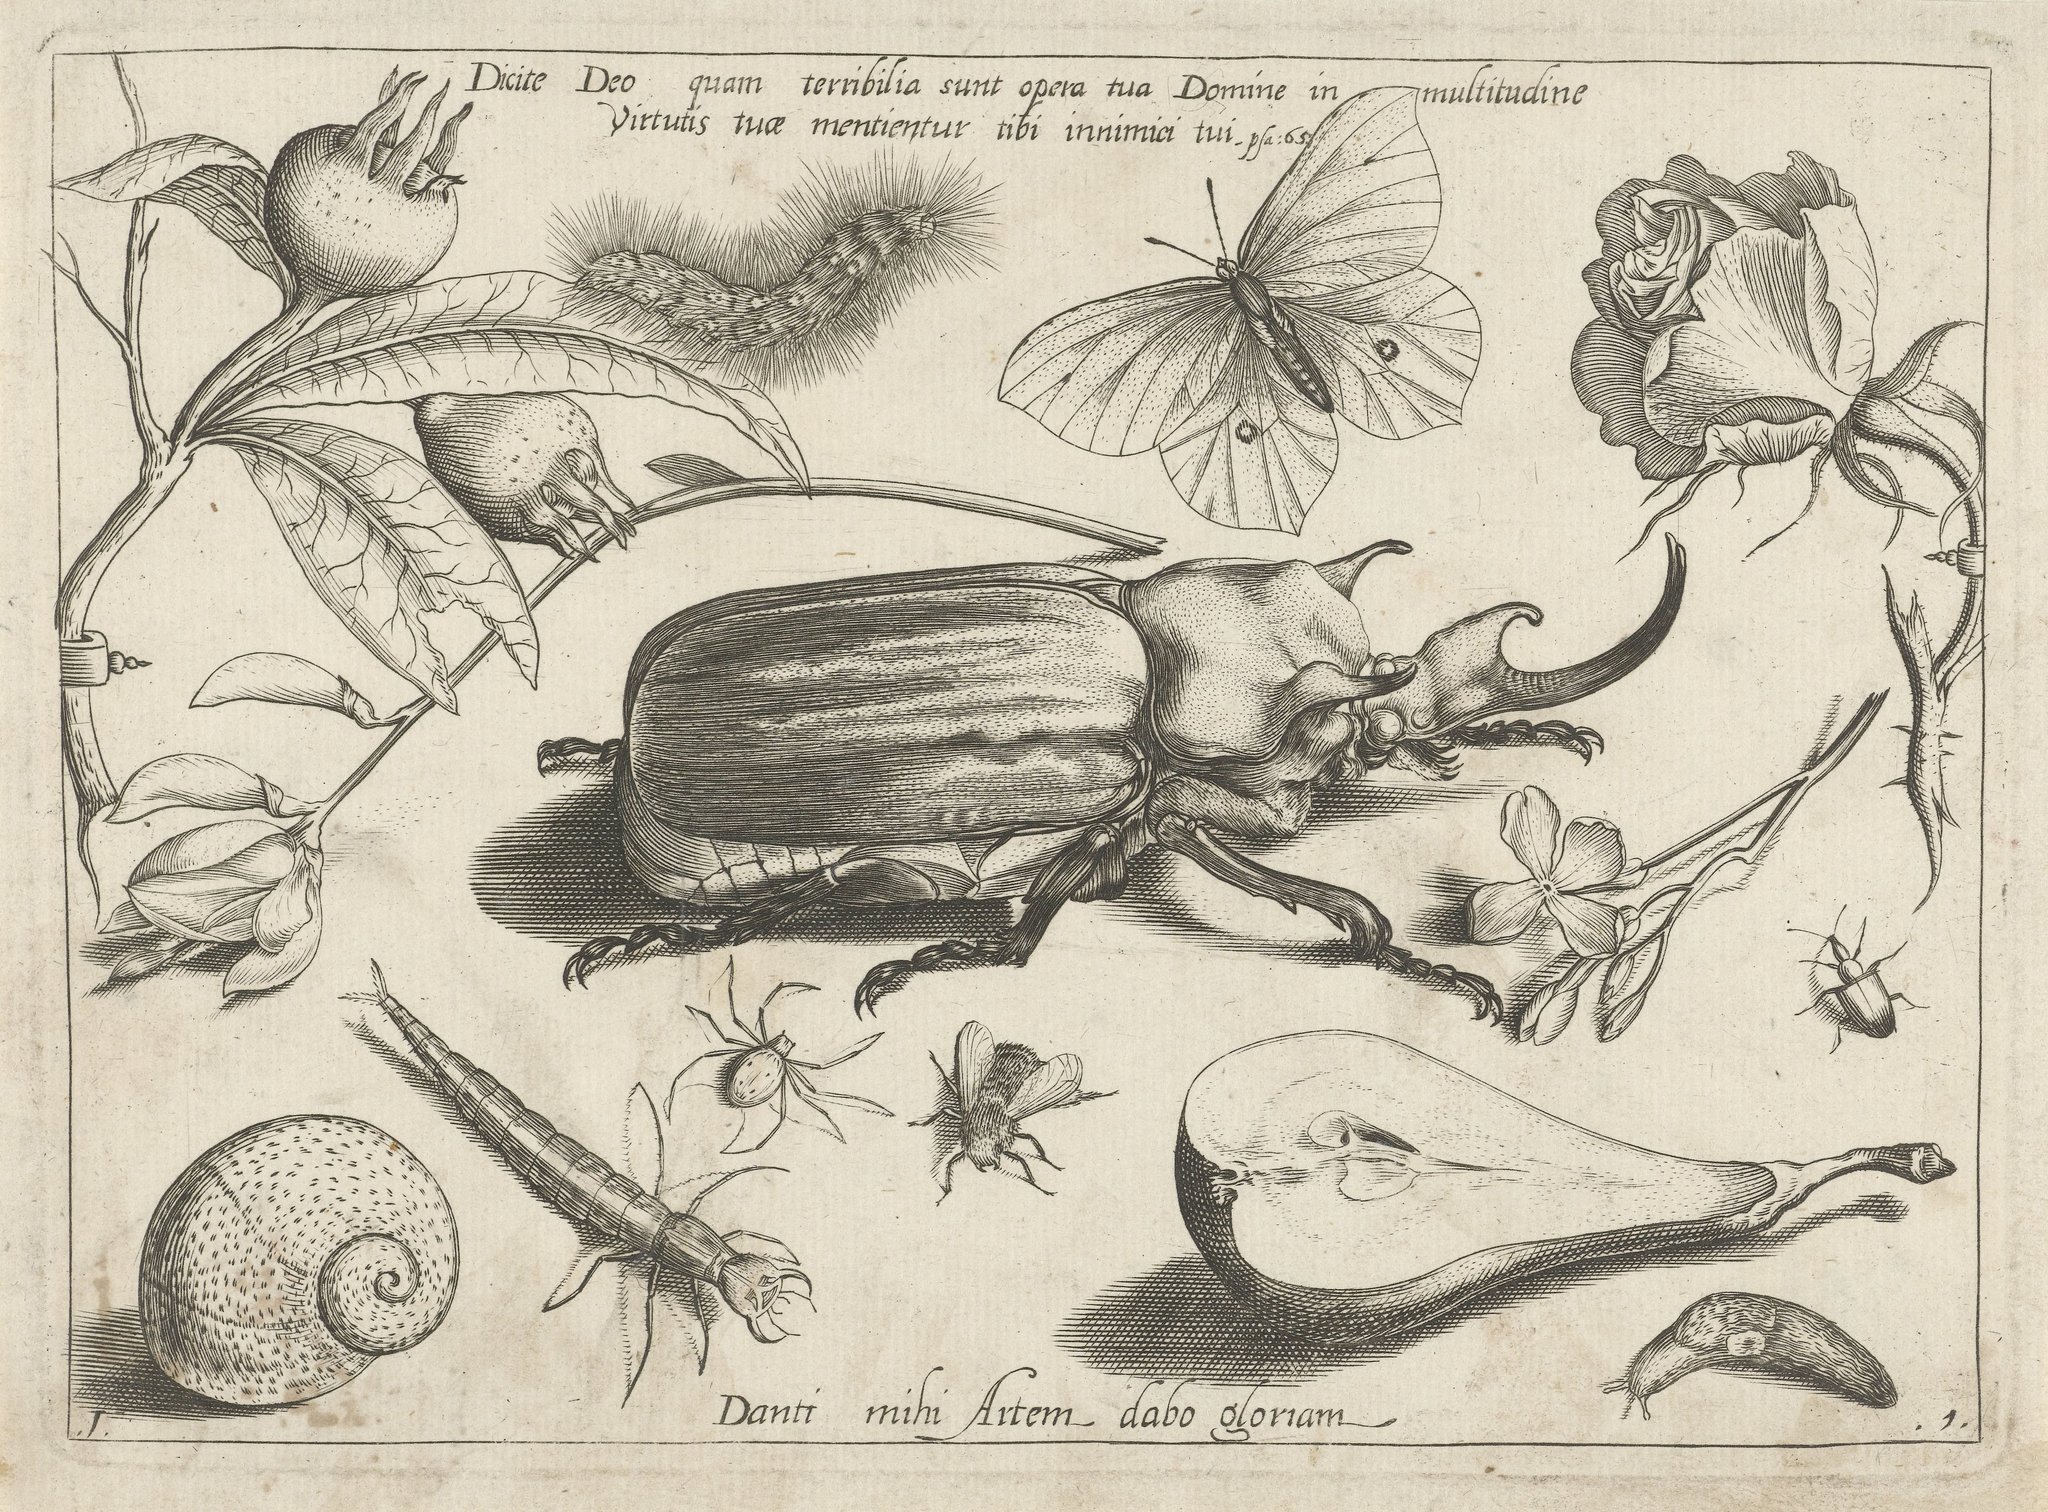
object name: print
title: Archetypa studiaque patris GeorgiI HoefnageliI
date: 1592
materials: paper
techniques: engraving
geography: frankfurt am main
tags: fruits: medlar, fruits: pear, flowers: rose, molluscs: snail, insects, insects: beetle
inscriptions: collector's mark: Lugt 2228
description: Prent uit een serie van 48 prenten, opgedeeld in vier afzonderlijke delen van elk twaalf prenten. Rechtsonder vermeld: [deel] 1. Boven- en onderaan een tekst in het Latijn.